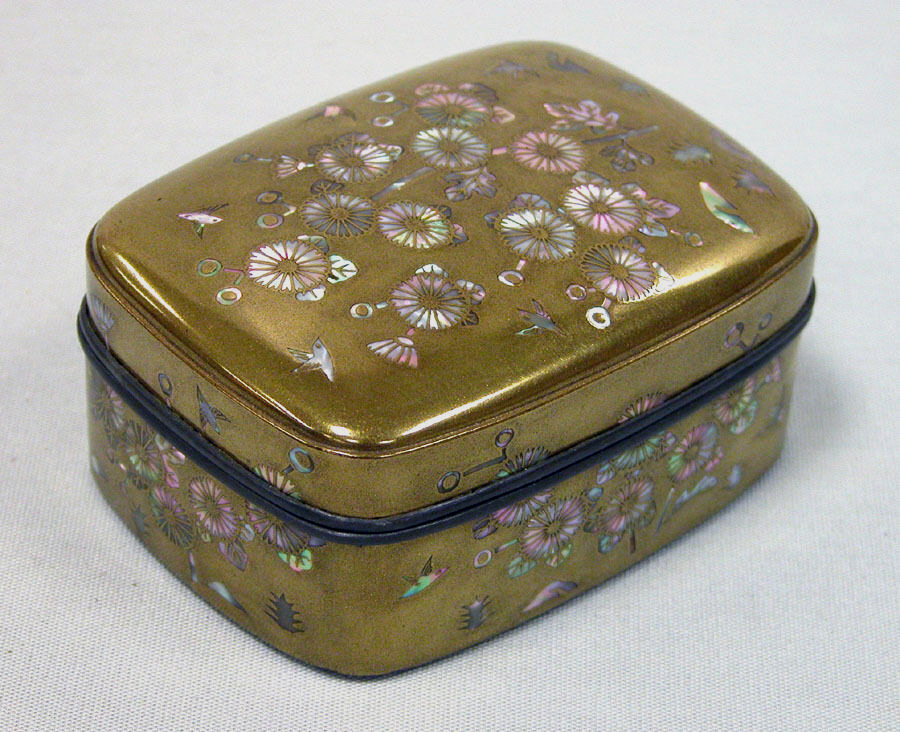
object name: covered box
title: Incense Box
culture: japanese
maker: ogawa shomin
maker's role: artist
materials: gold, gold leaf, mother of pearl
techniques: hiramakie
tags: birds,flowers